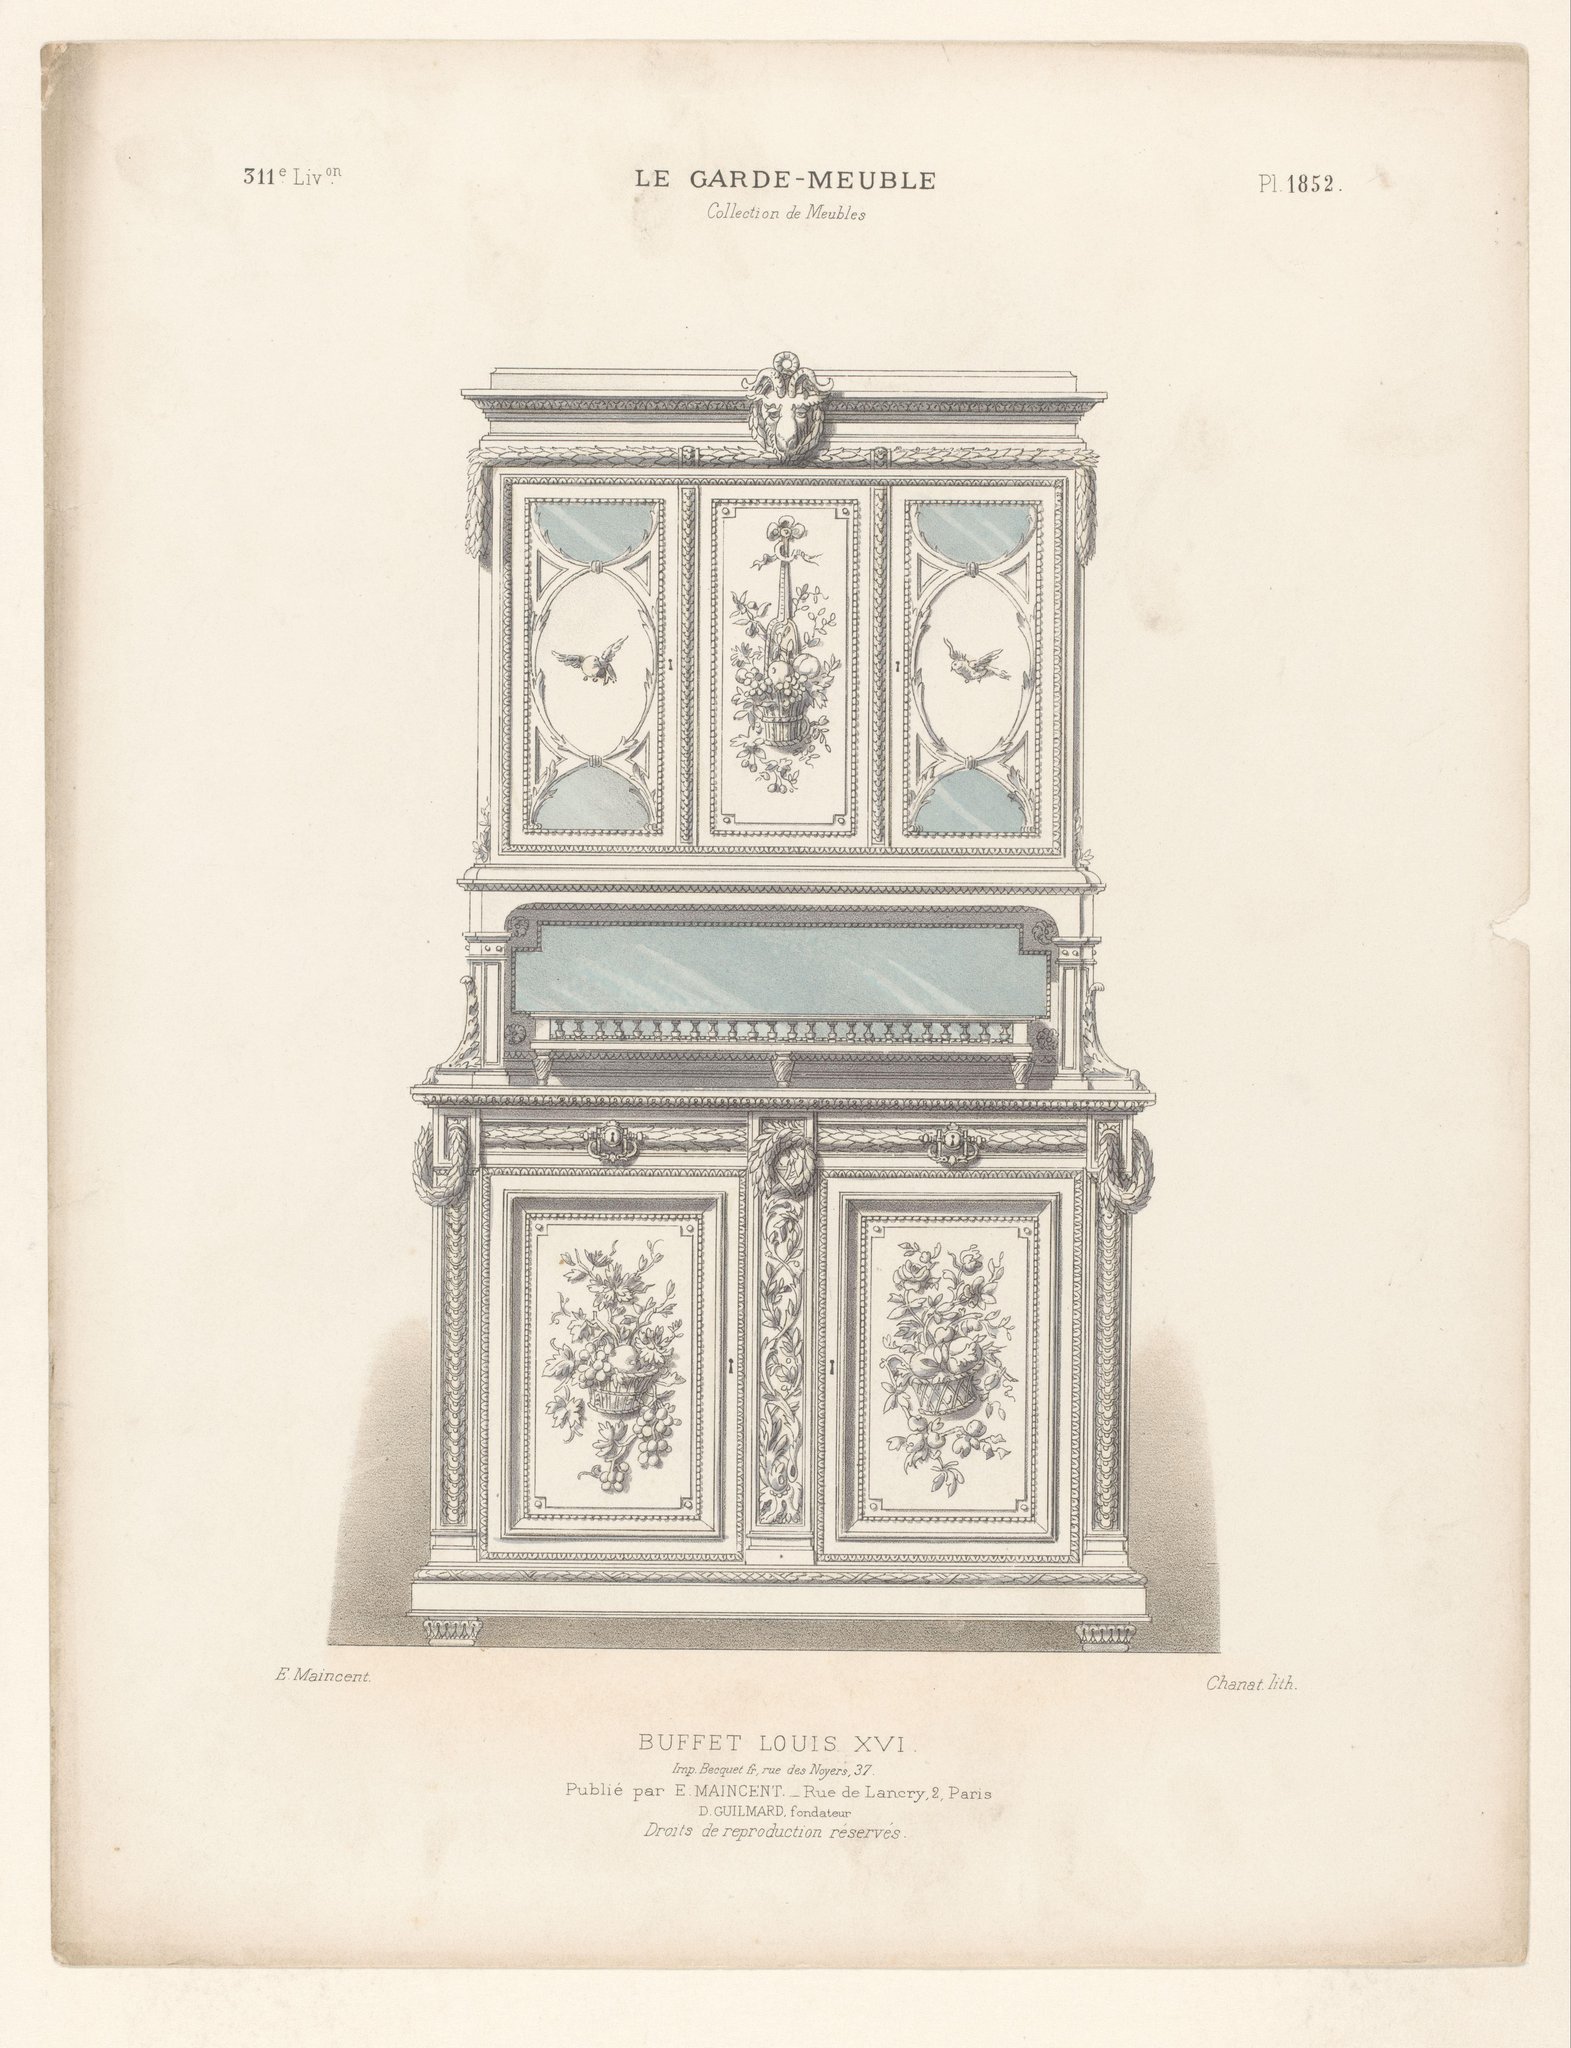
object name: print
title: Buffet Louis XVI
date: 1885-1895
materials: paper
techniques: hand coloring, lithograph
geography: paris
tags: furniture for storage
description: Ieder Livraison in de serie Le Garde-Meuble bevat negen platen: drie 'sièges' (zitmeubels), drie 'meubles' (diverse meubels zoals tafels en kasten) en drie 'tentures' (gordijnen en draperieën).